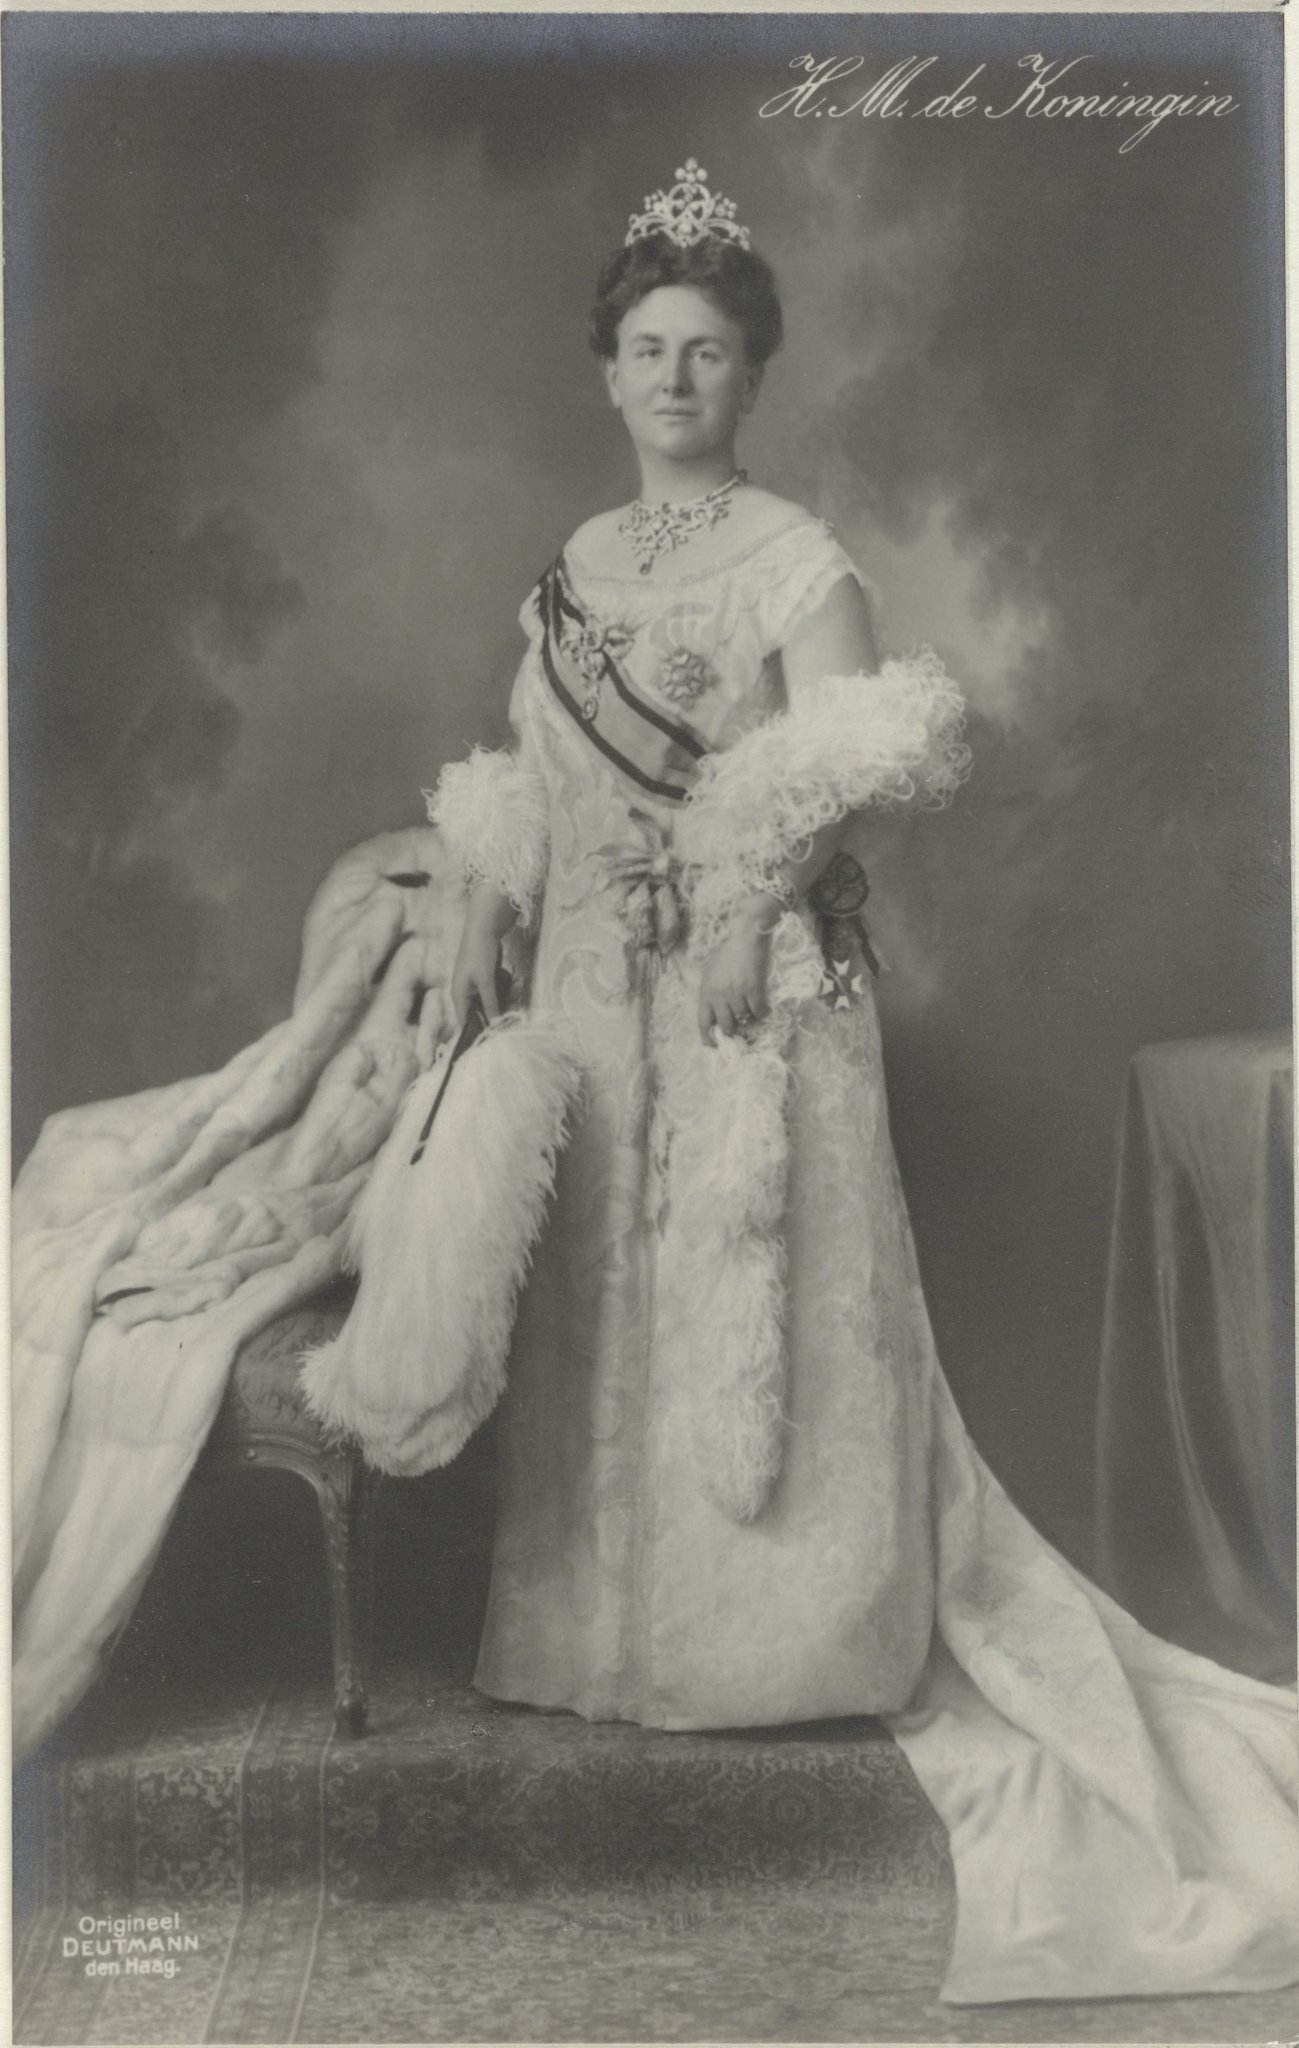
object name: photograph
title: Portret van Wilhelmina, koningin der Nederlanden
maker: herman deutmann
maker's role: fotograaf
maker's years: 1870-1926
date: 1920-1926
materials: photographic support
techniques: photography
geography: the hague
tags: print maker, wilhelmina of the netherlands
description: De hier vermelde titel verwijst naar de hoogst verkregen titel van de geportretteerde, niet per se naar de titel die de geportretteerde op deze voorstelling draagt.